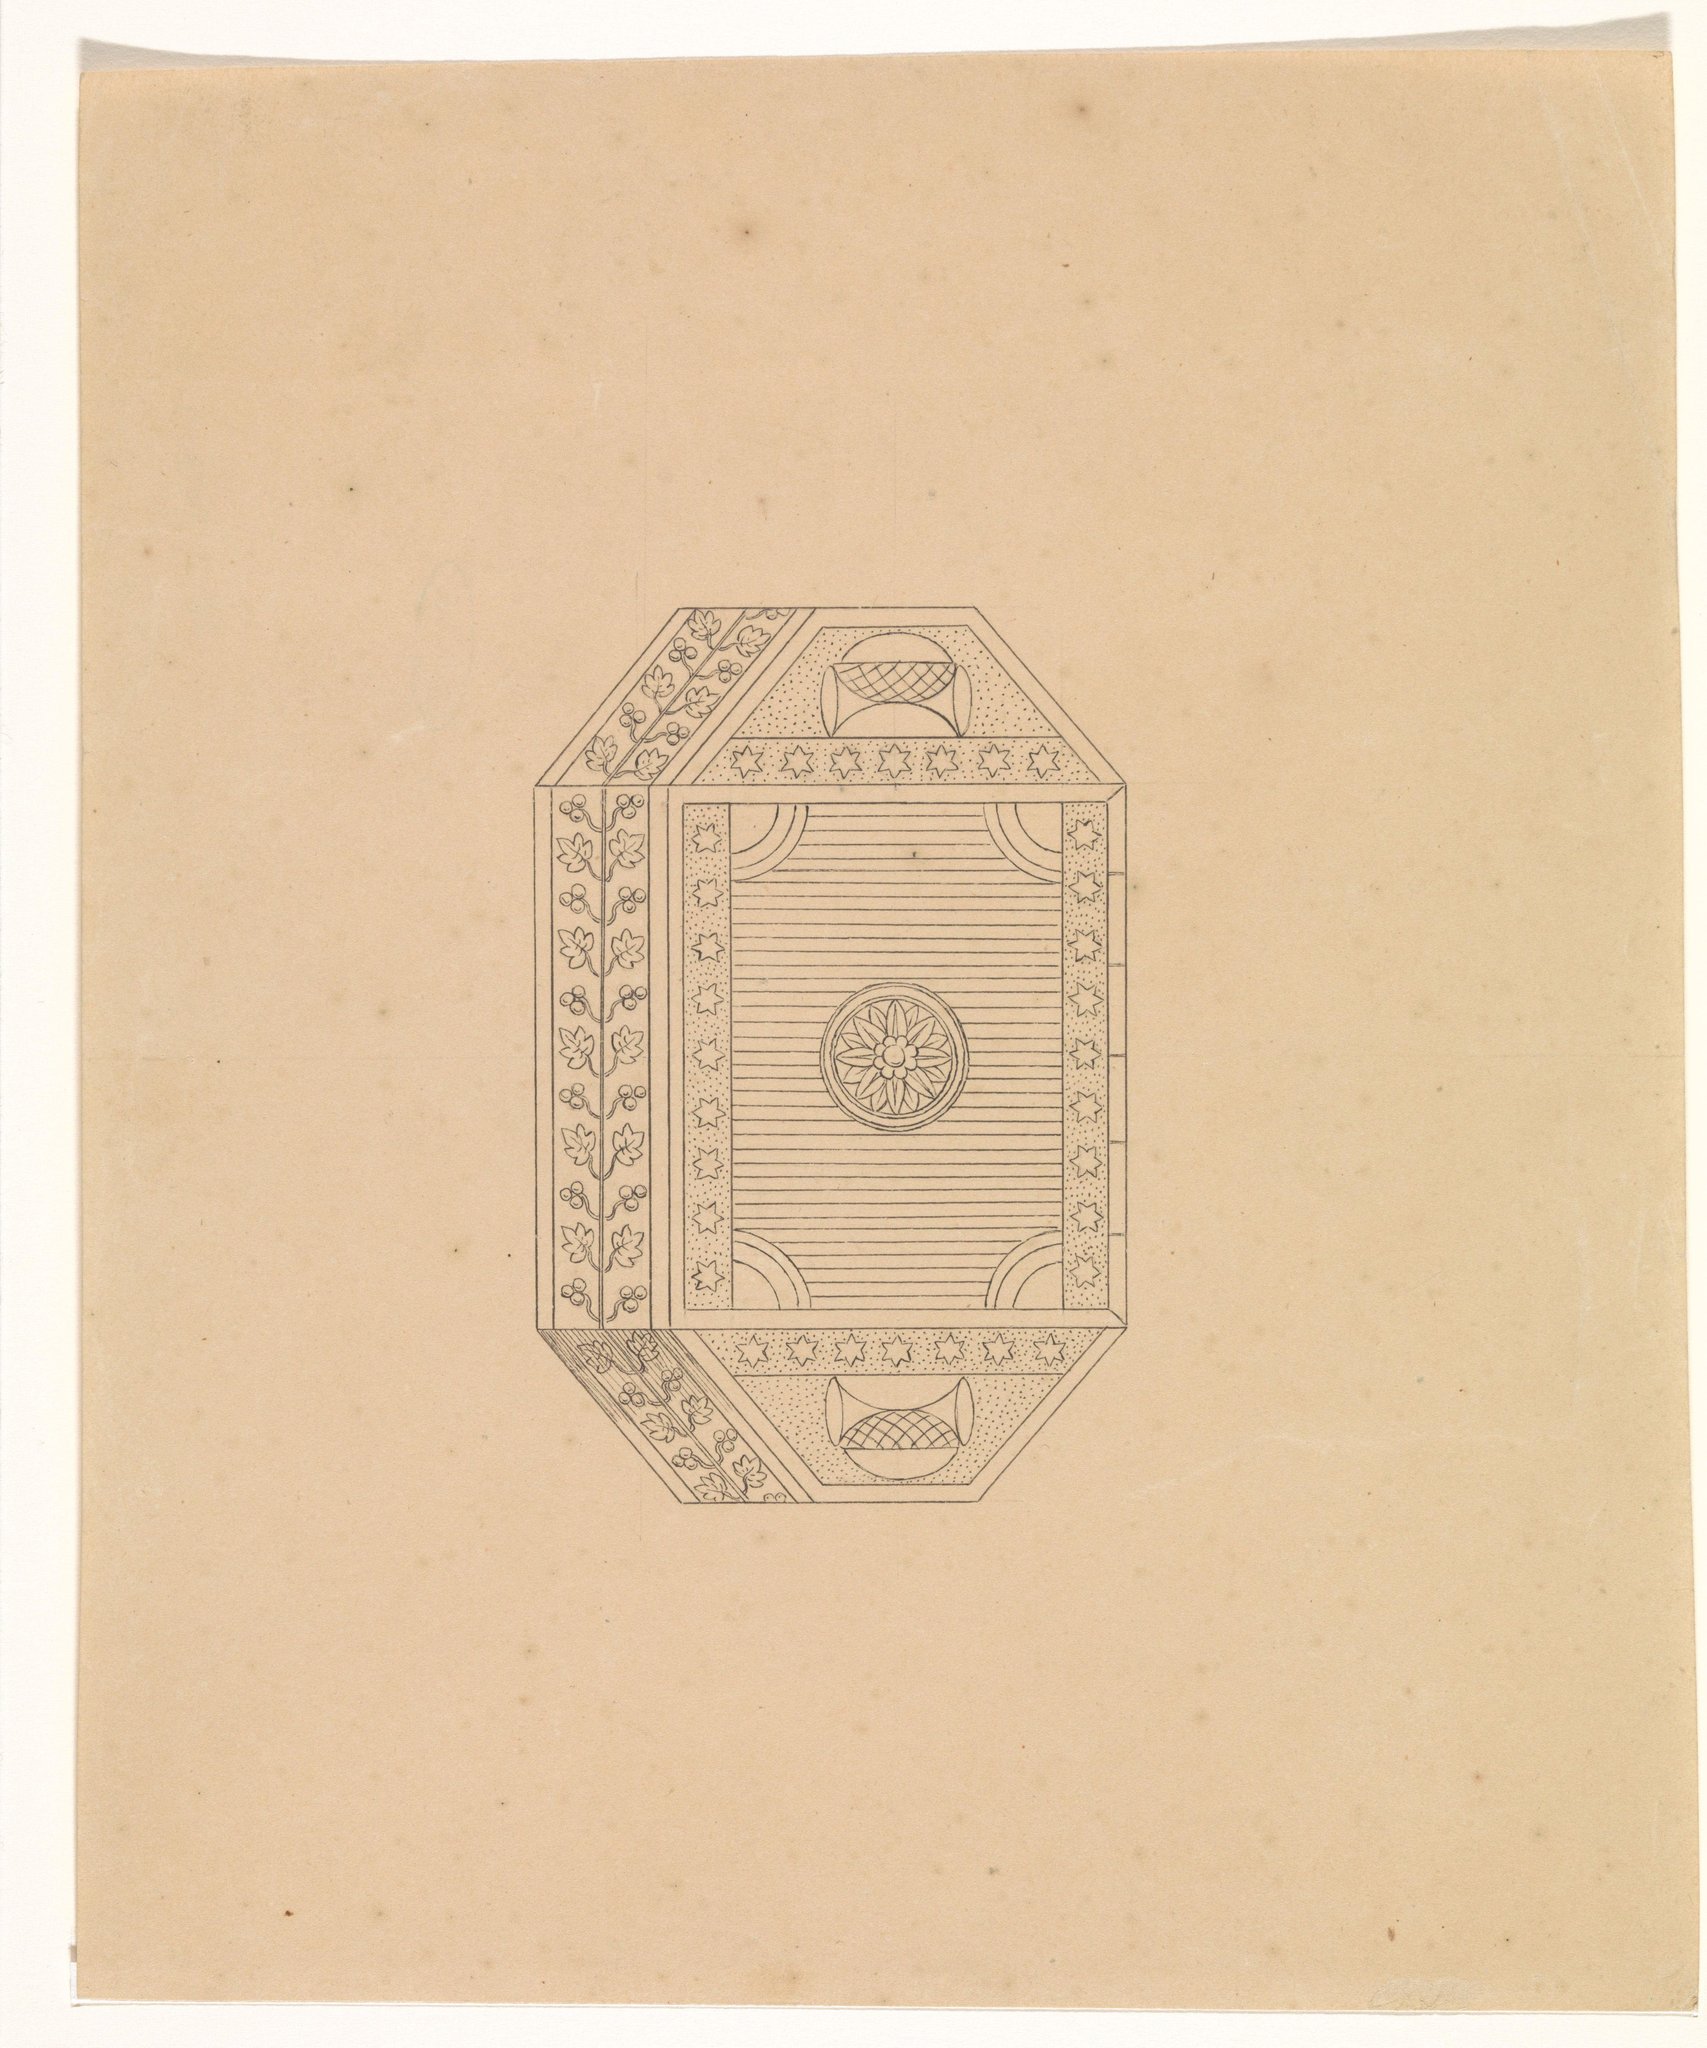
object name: drawing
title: Snuifdoos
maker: Anonymous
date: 1800-1820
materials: paper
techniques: pen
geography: germany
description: Rechthoekige snuifdoos met afgeschuinde hoeken, met gegraveerde decoratie.